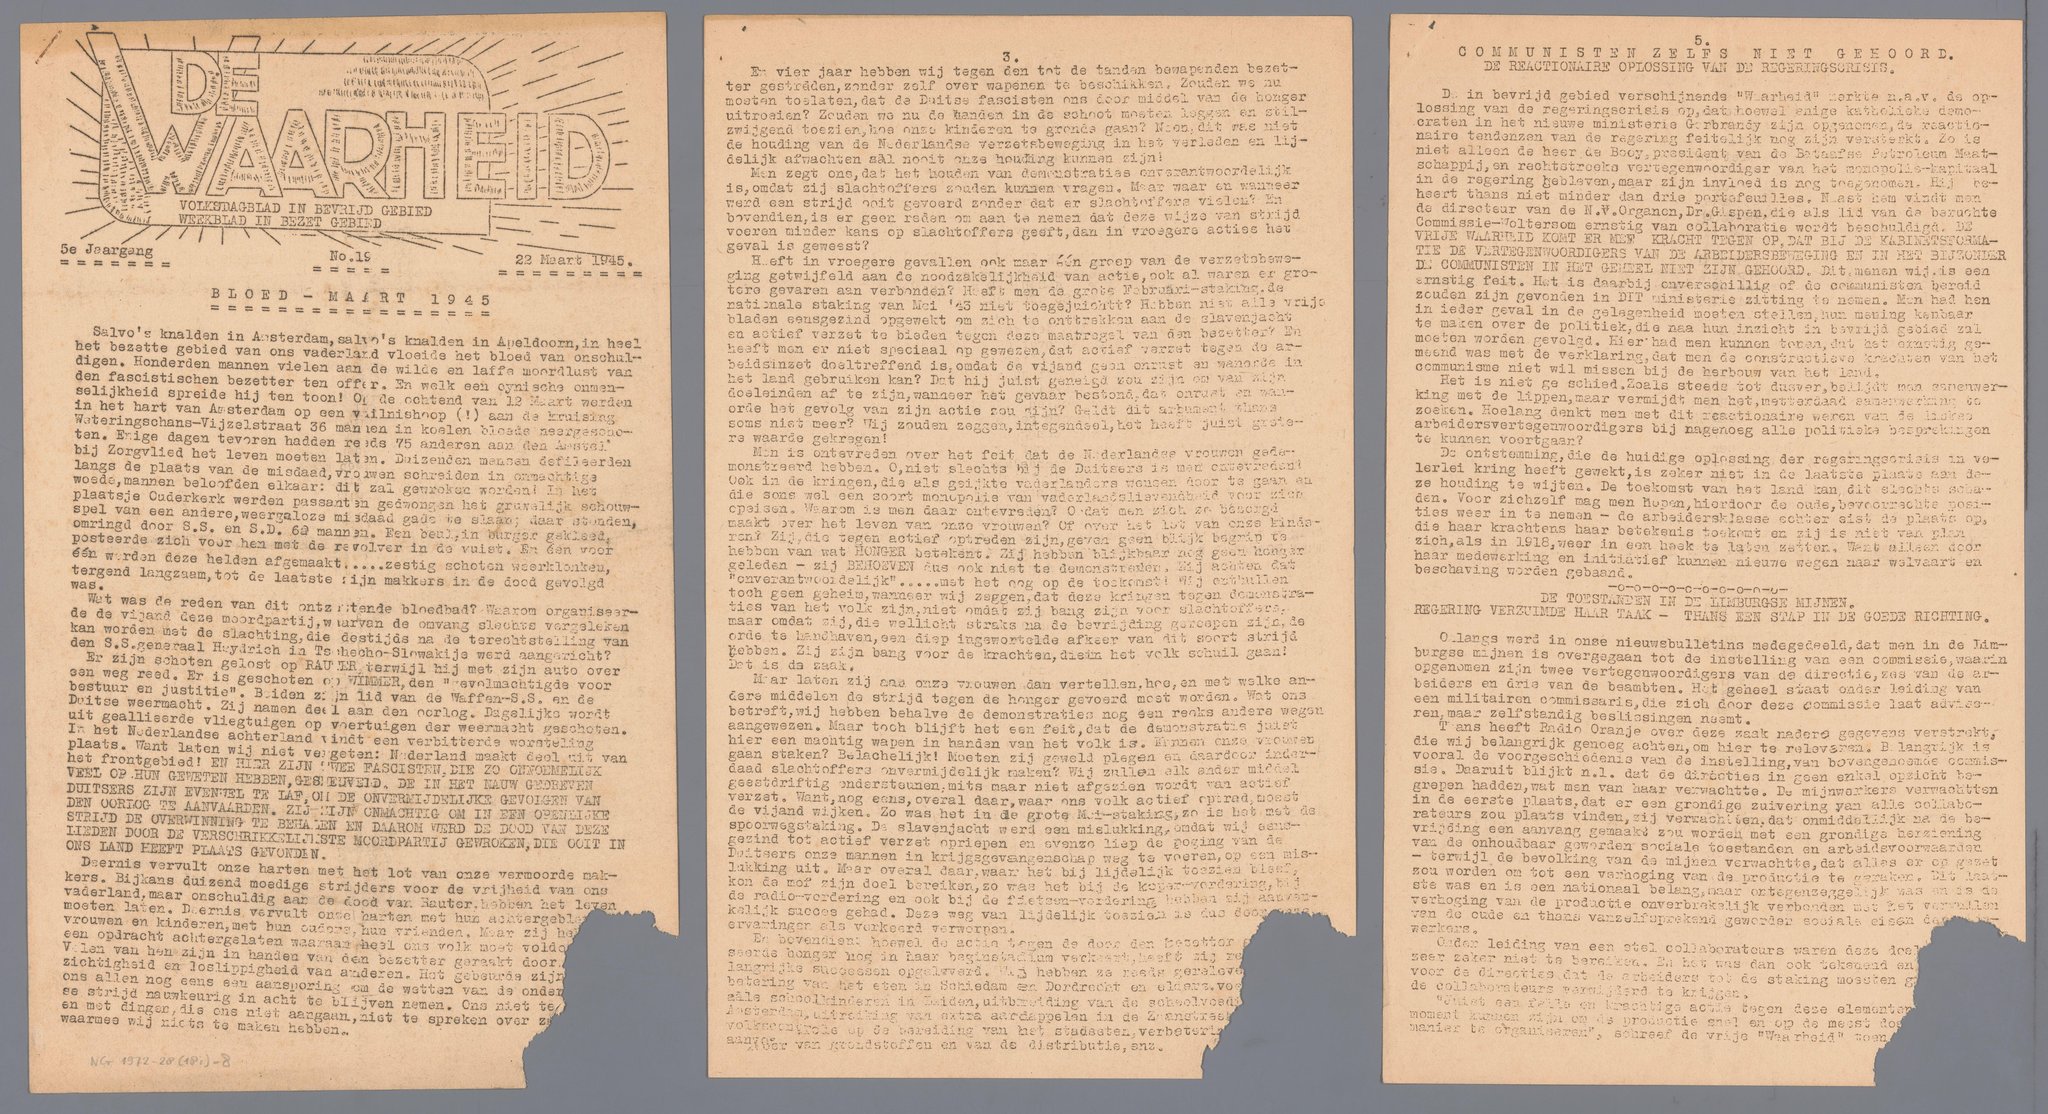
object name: newspaper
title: De Waarheid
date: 1945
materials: paper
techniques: mimeography, printing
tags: netherlands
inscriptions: date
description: Nummer van het illegale blad 'De Waarheid': No 19 'Bloed Maart 1945', 6 pp. Opschrift; l.b.: 'Volksdagblad voor bevrijd Nederlandd', r.b. 'Uitgave voor het bezette gebied'. Gedateerd: boven.